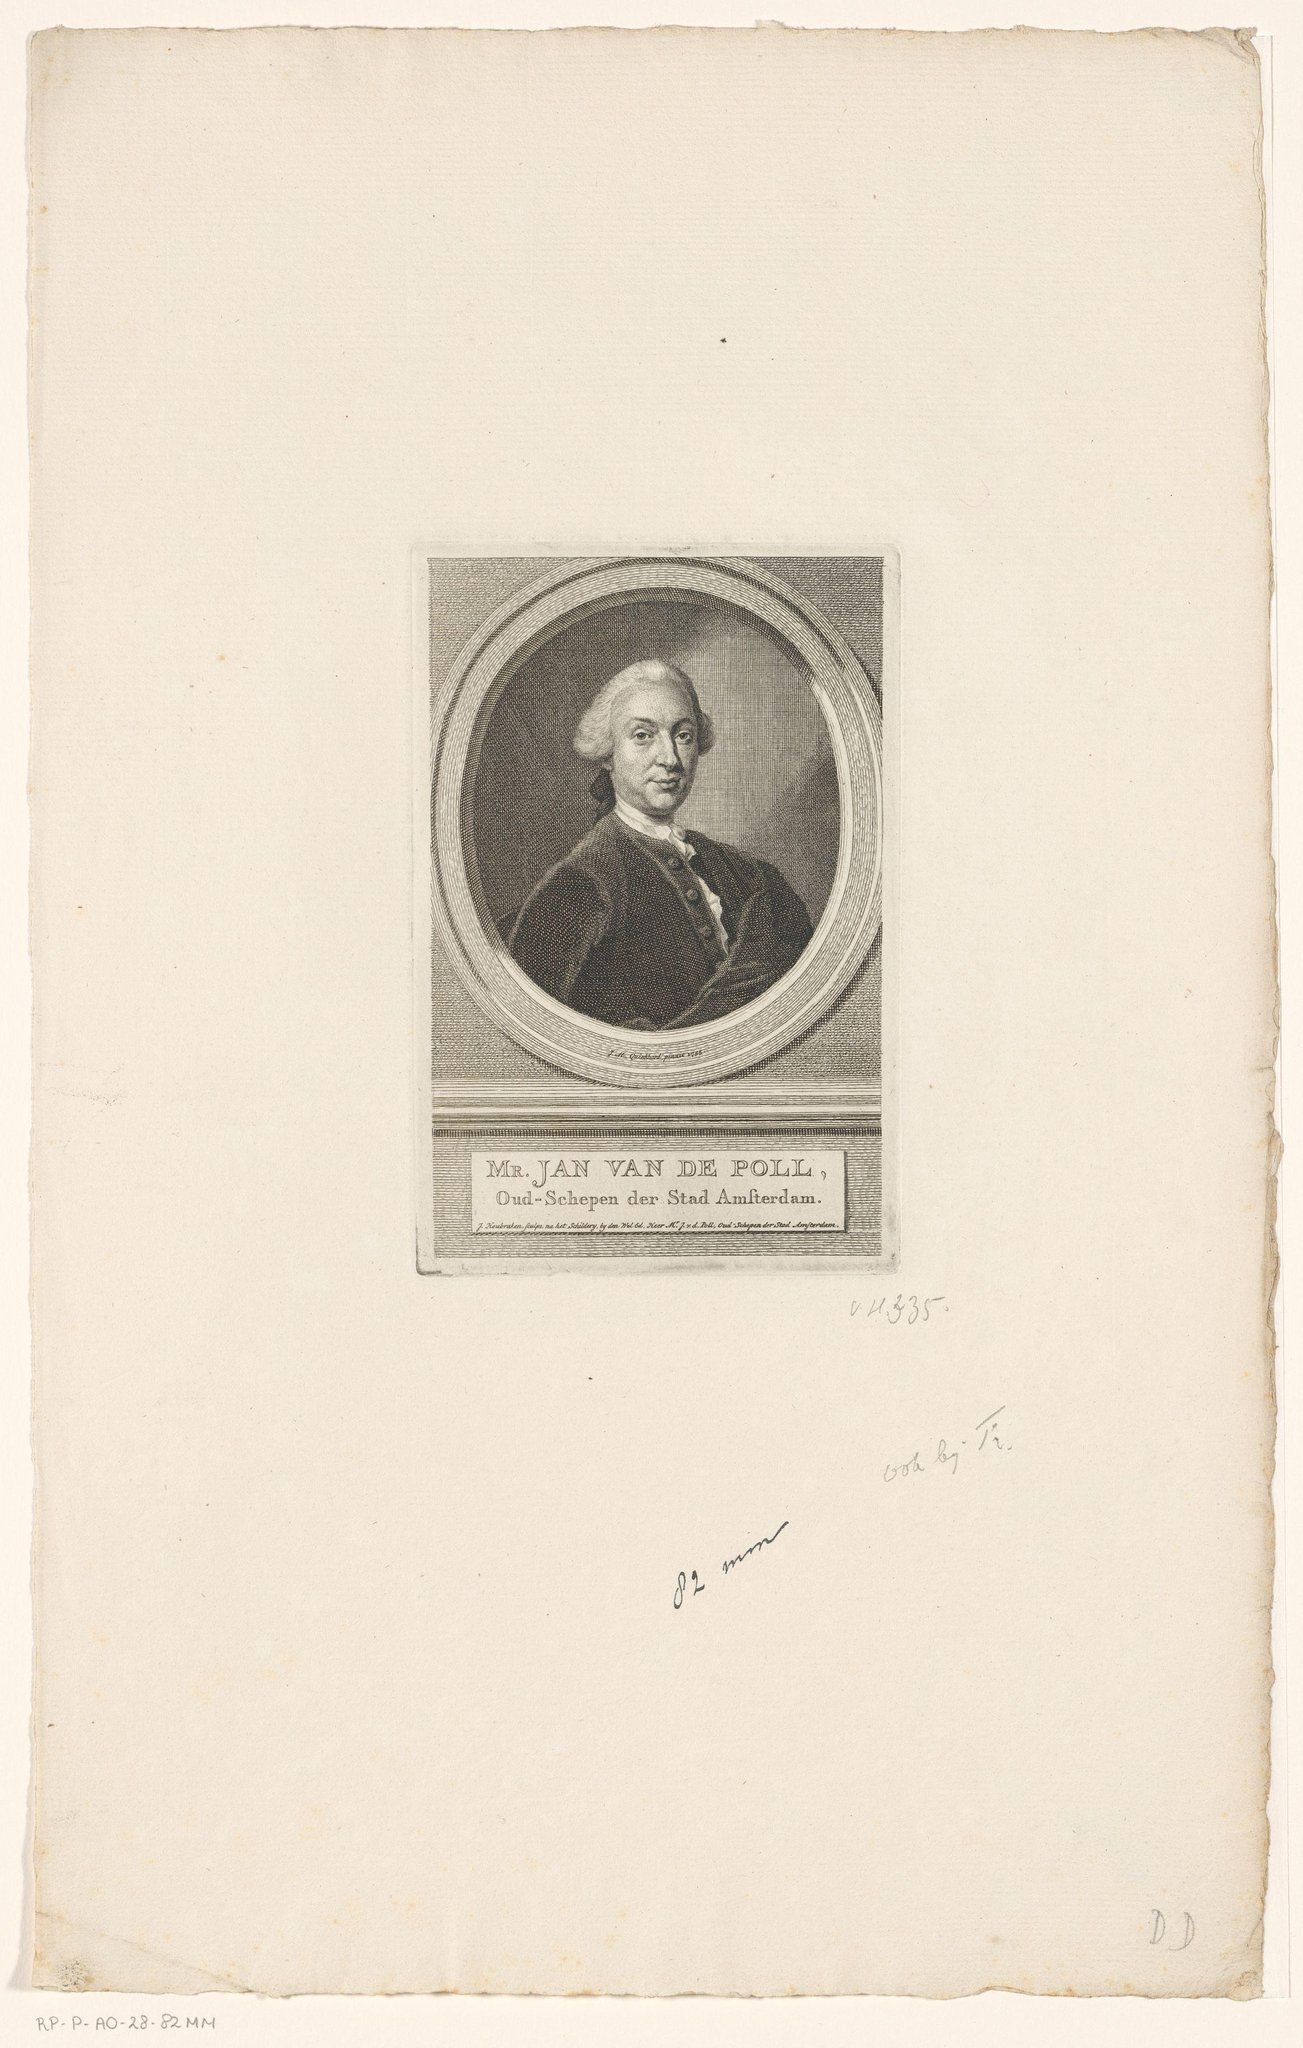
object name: print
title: Portret van Jan van de Poll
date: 1749-1780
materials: paper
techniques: engraving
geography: amsterdam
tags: historical persons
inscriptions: collector's mark: Lugt 2228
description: Deze prent is oorspronkelijk bedoeld als aanvulling op Jan Wagenaars ‘Vaderlandsche historie’* en was zo vanaf 1796 verkrijgbaar bij Johannes Allart te Amsterdam. Voor de advertentie waarin Allart de 60 portretten en 7 platen, allen gegraveerd door Houbraken, ter aanvulling op Wagenaars ‘Vaderlandsche historie’ aanbiedt, zie RP-P-OB-77.766. *Van dit werk zijn in de achttiende eeuw meerdere uitgaves verschenen, zoals: Wagenaar, Jan. Vaderlandsche historie, vervattende de geschiedenissen der Vereenigde Nederlanden (…). 21 delen. Amsterdam: Isaak Tirion, 1749-1759. Wagenaar, Jan. Vaderlandsche historie, vervattende de geschiedenissen der nu Vereenigde Nederlanden (…). 21 delen. Amsterdam: weduwe Isaak Tirion, 1770. Wagenaar, Jan. Vaderlandsche historie, vervattende de geschiedenissen der nu Vereenigde Nederlanden (…). 21 delen. Amsterdam, Leiden, Dordrecht en Harlingen: P. Schouten e.a., 1782. Wagenaar, Jan. Vaderlandsche historie, vervattende de geschiedenissen der nu Vereenigde Nederlanden (…). 21 delen. Amsterdam: Johannes Allart, 1790-1796.